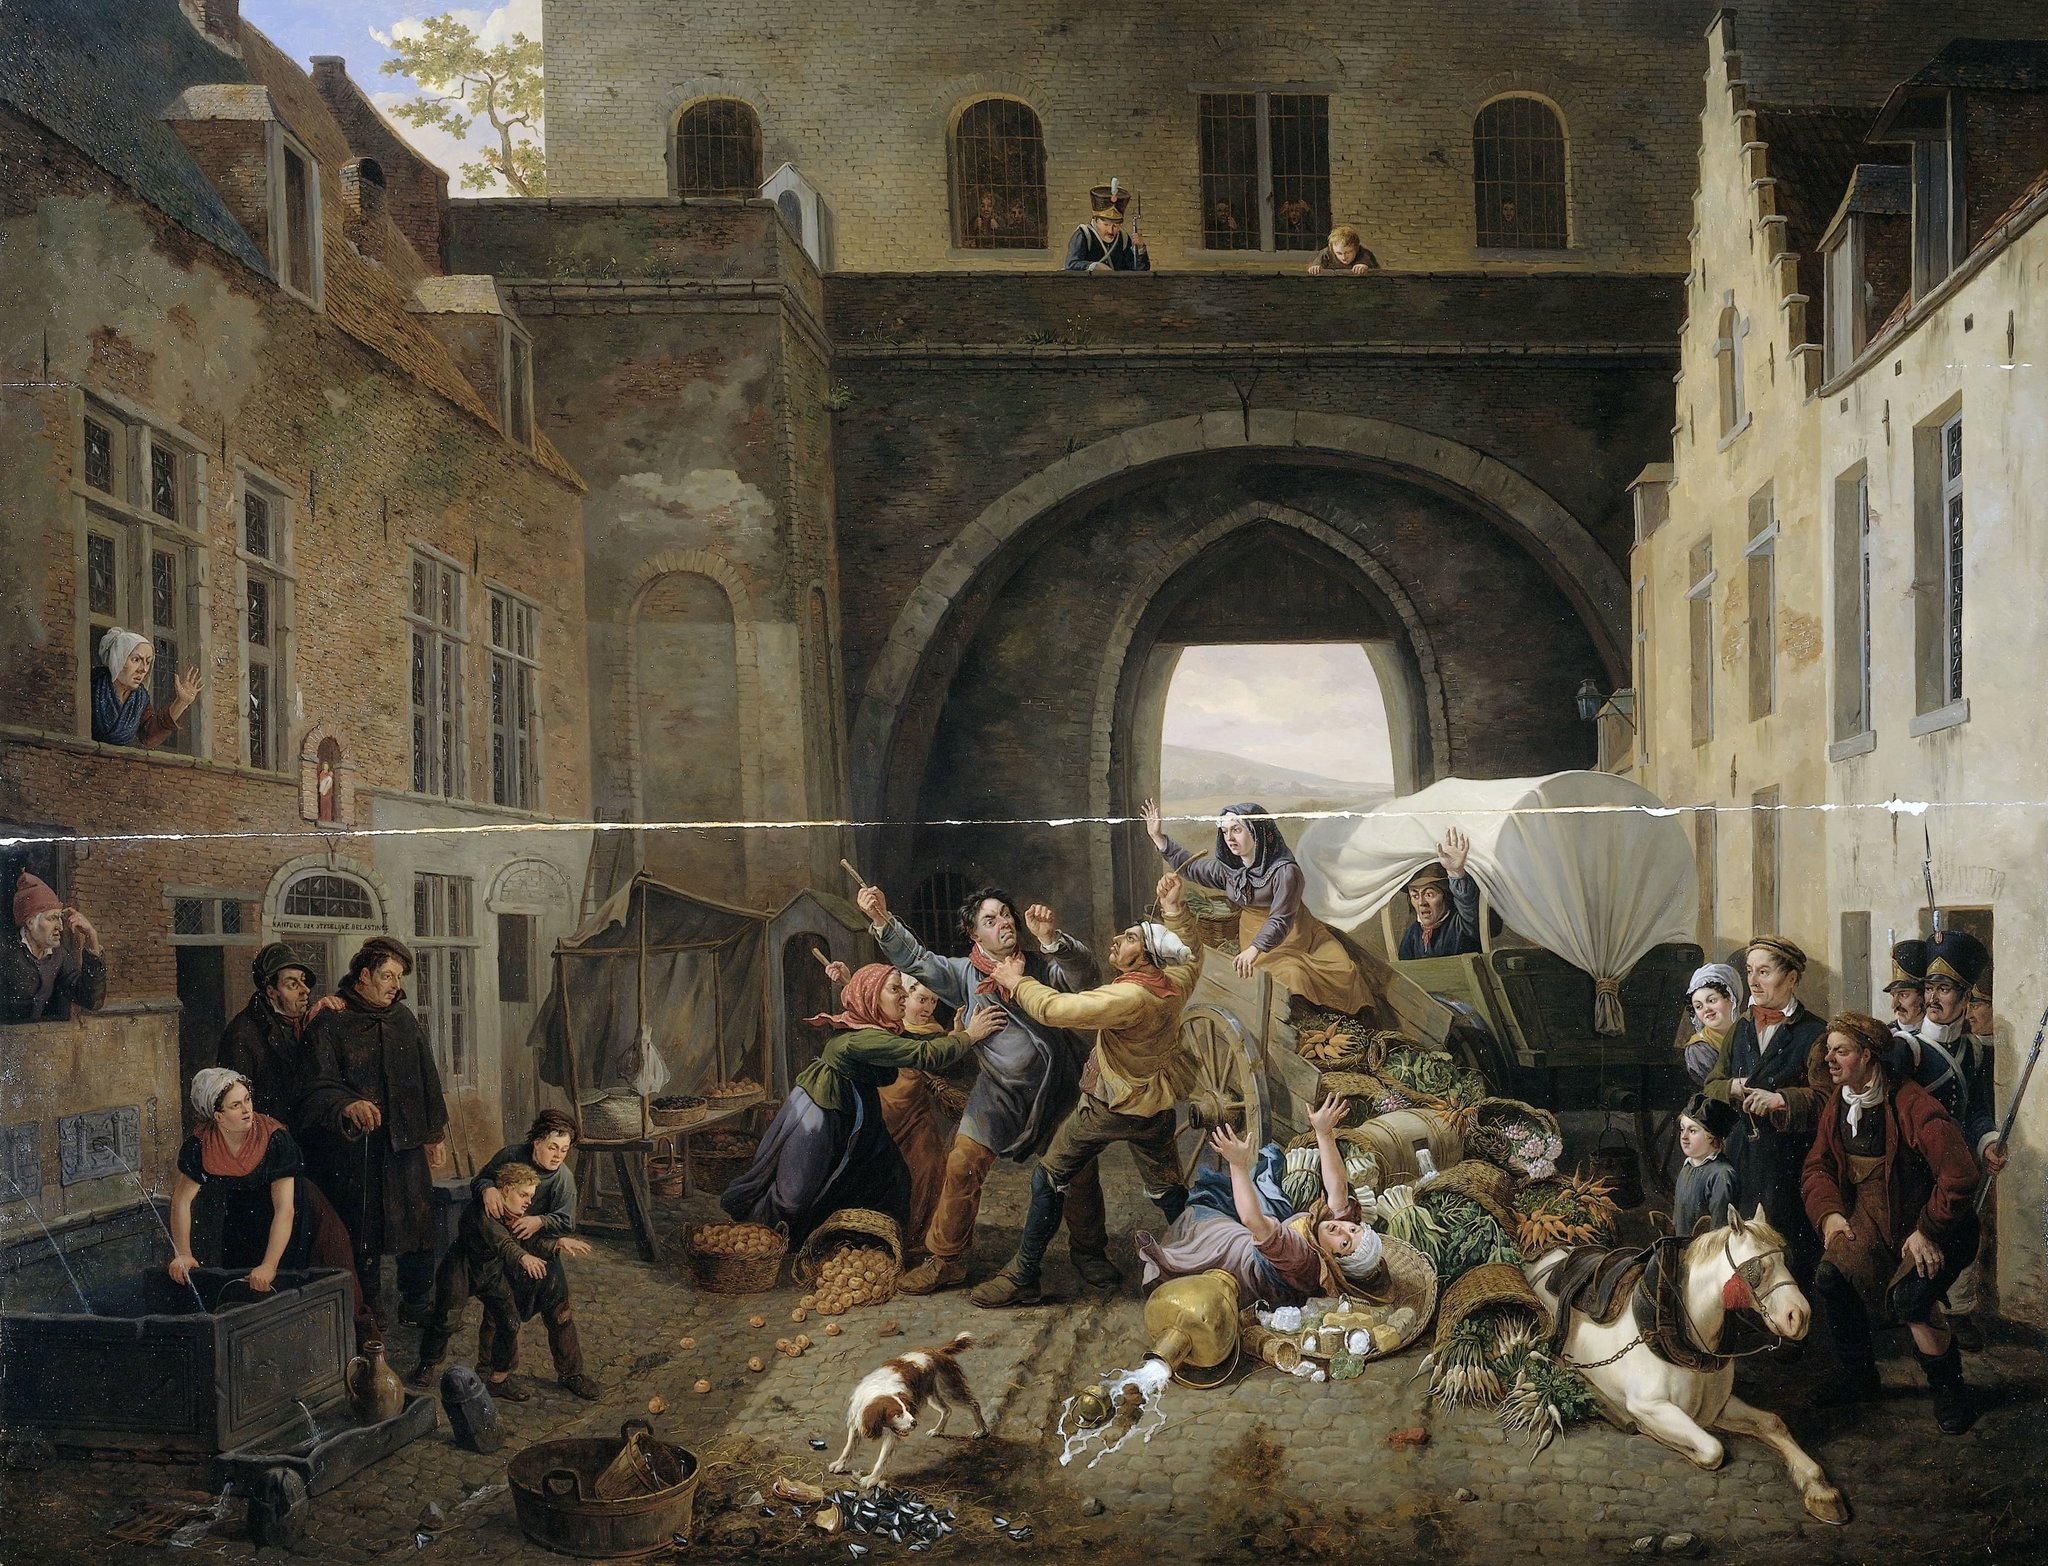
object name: painting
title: A Collision at the Porte de Hal, Brussels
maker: constantinus fidelio coene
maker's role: draughtsman, painter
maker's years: 1779-1841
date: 1823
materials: oil, panel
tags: two-wheeled, animal-drawn vehicle (+ accident, collision, crash ~ traffic and transport), stall, booth (~ market), brussels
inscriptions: signature and date: ‘C. Coene 1823’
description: Een aanrijding bij de Hallepoort te Brussel. Een vechtpartij tussen twee voerlieden na een botsing tussen twee wagens. Een vrouw spartelt tussen de omgevallen manden met groenten en melkbussen. Links het belastingkantoor en een fontein.